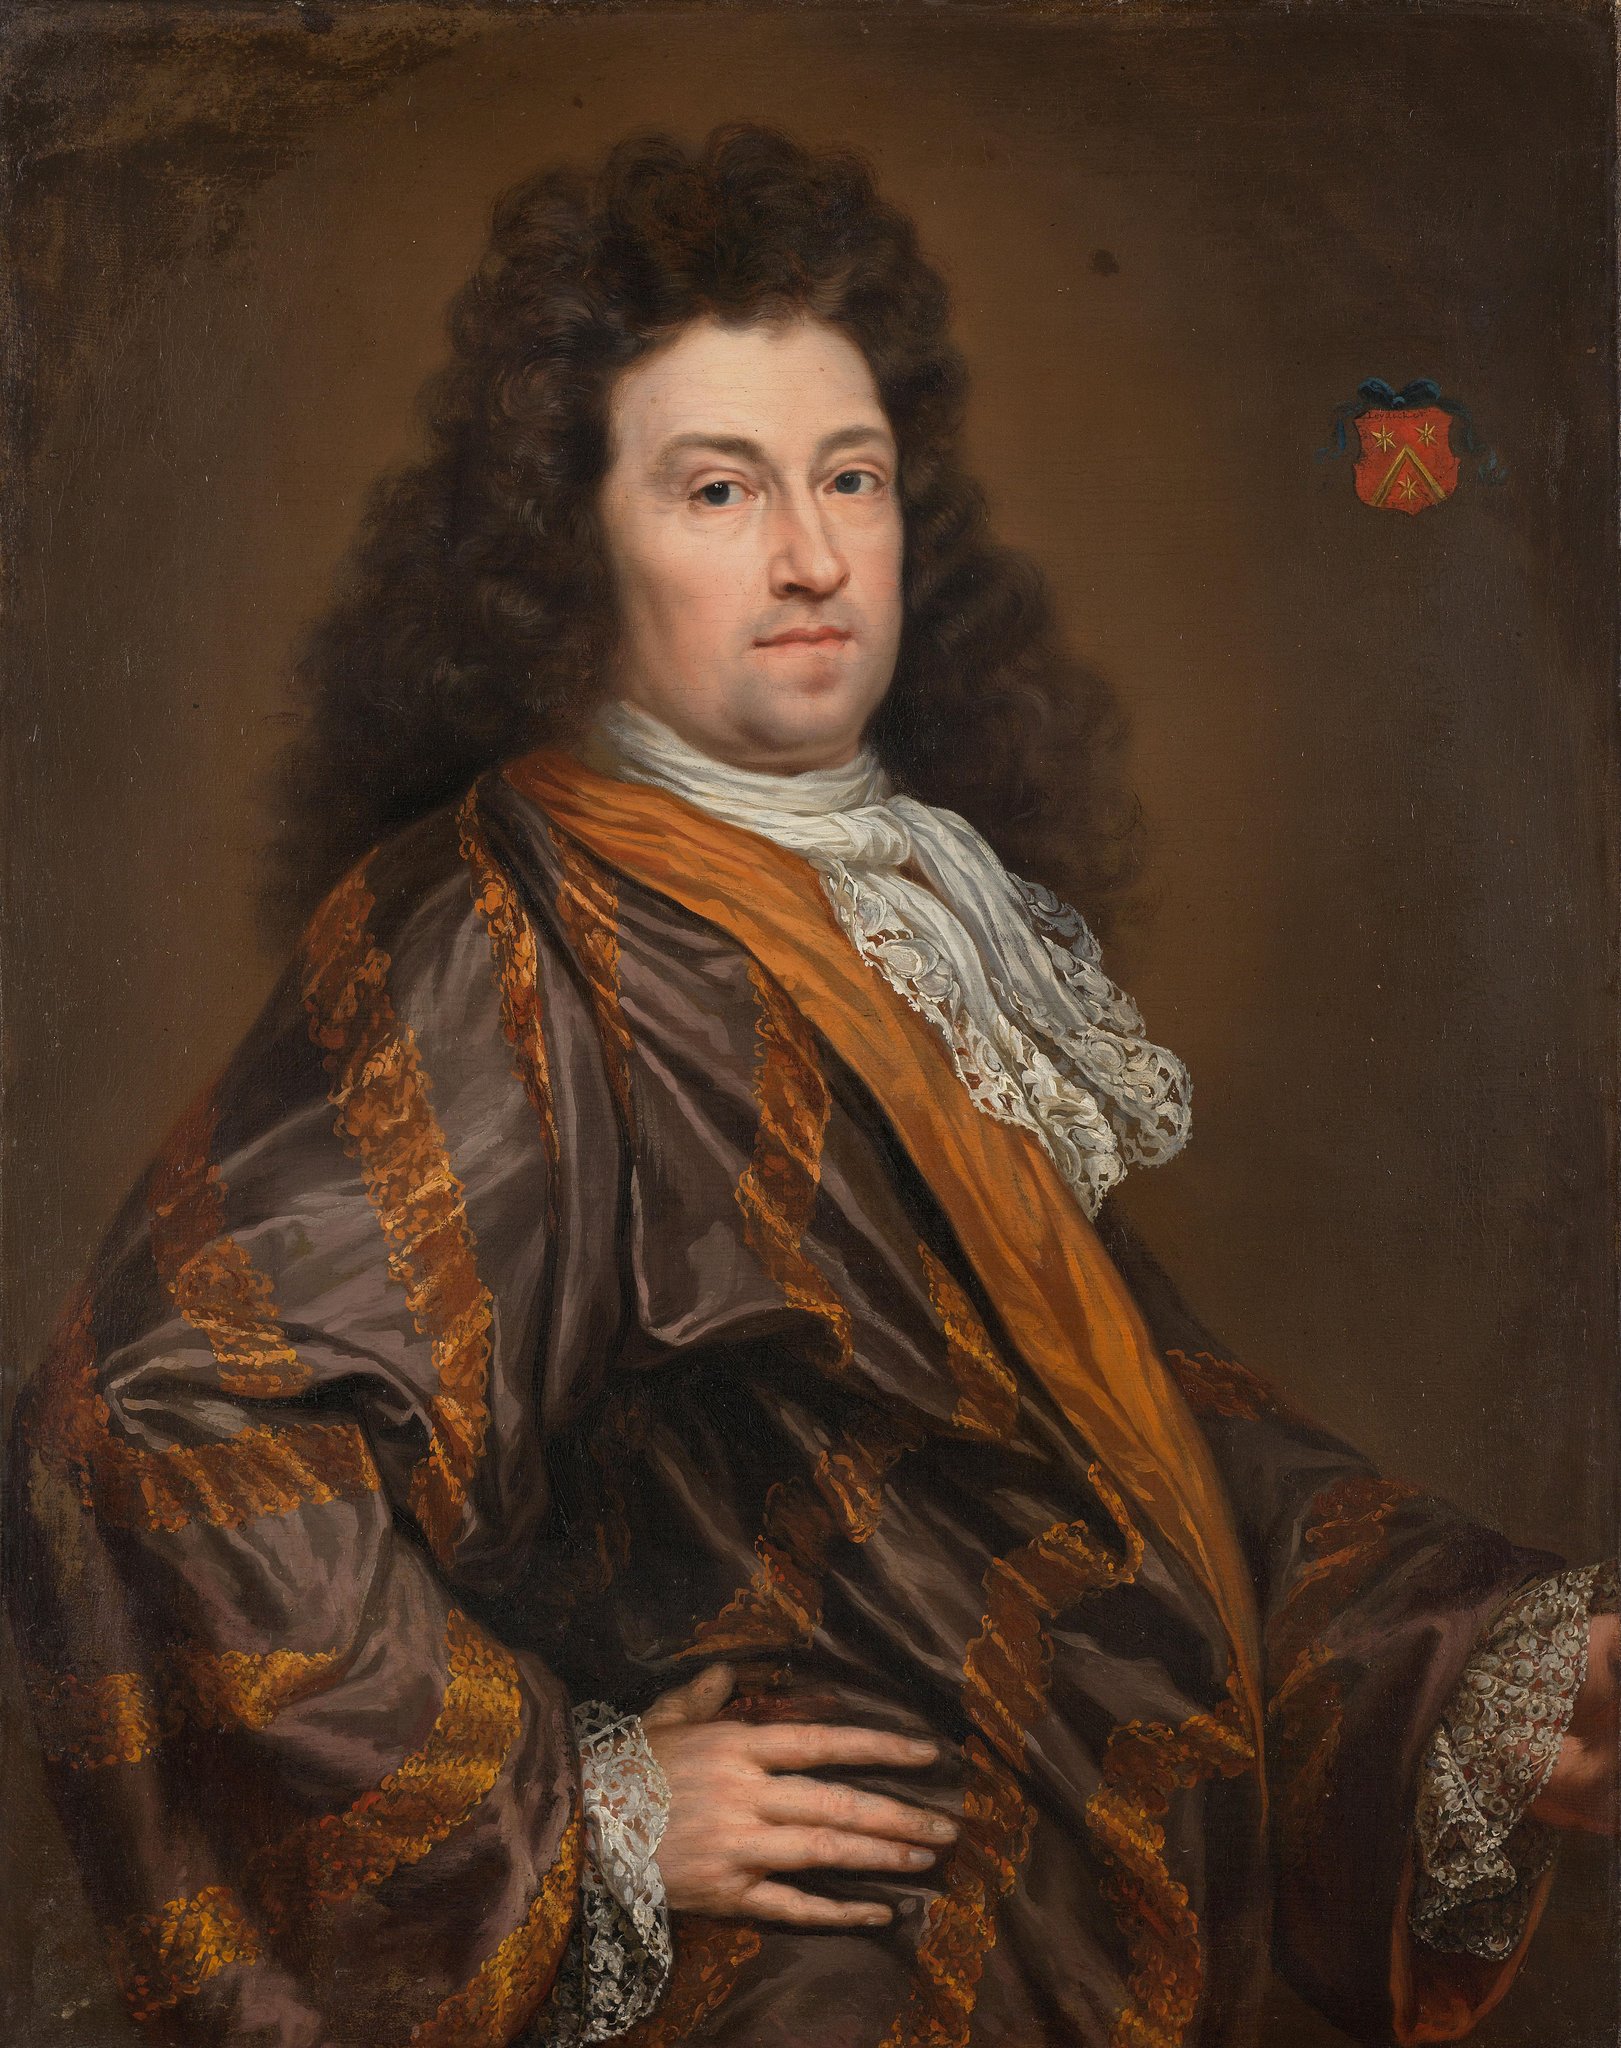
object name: painting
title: Portrait of François Leydecker (1650-1718). Delegate to the Court of Audit for Zeeland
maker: Anonymous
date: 1690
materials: canvas, oil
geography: netherlands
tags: historical persons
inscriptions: inscription: ‘D'Heer Fransois Leydecker Gediputeert ter Generaliteits Rekenkamer Wegens de Provintie van Zeeland’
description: Portret van François Leydecker (1650-1718). Gedeputeerde ter Generaliteitsrekenkamer wegens Zeeland. Ten halven lijve naar rechts, staande, in Japonsche rock. Rechtsboven het familiewapen. Pendant van SK-A-827.